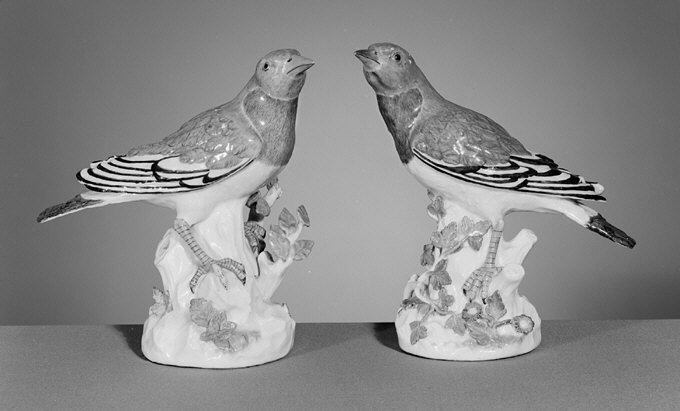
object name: figure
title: Thrush (one of a pair)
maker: meissen manufactory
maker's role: manufactory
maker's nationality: german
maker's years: 1710-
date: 1740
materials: hard paste porcelain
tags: birds,leaves